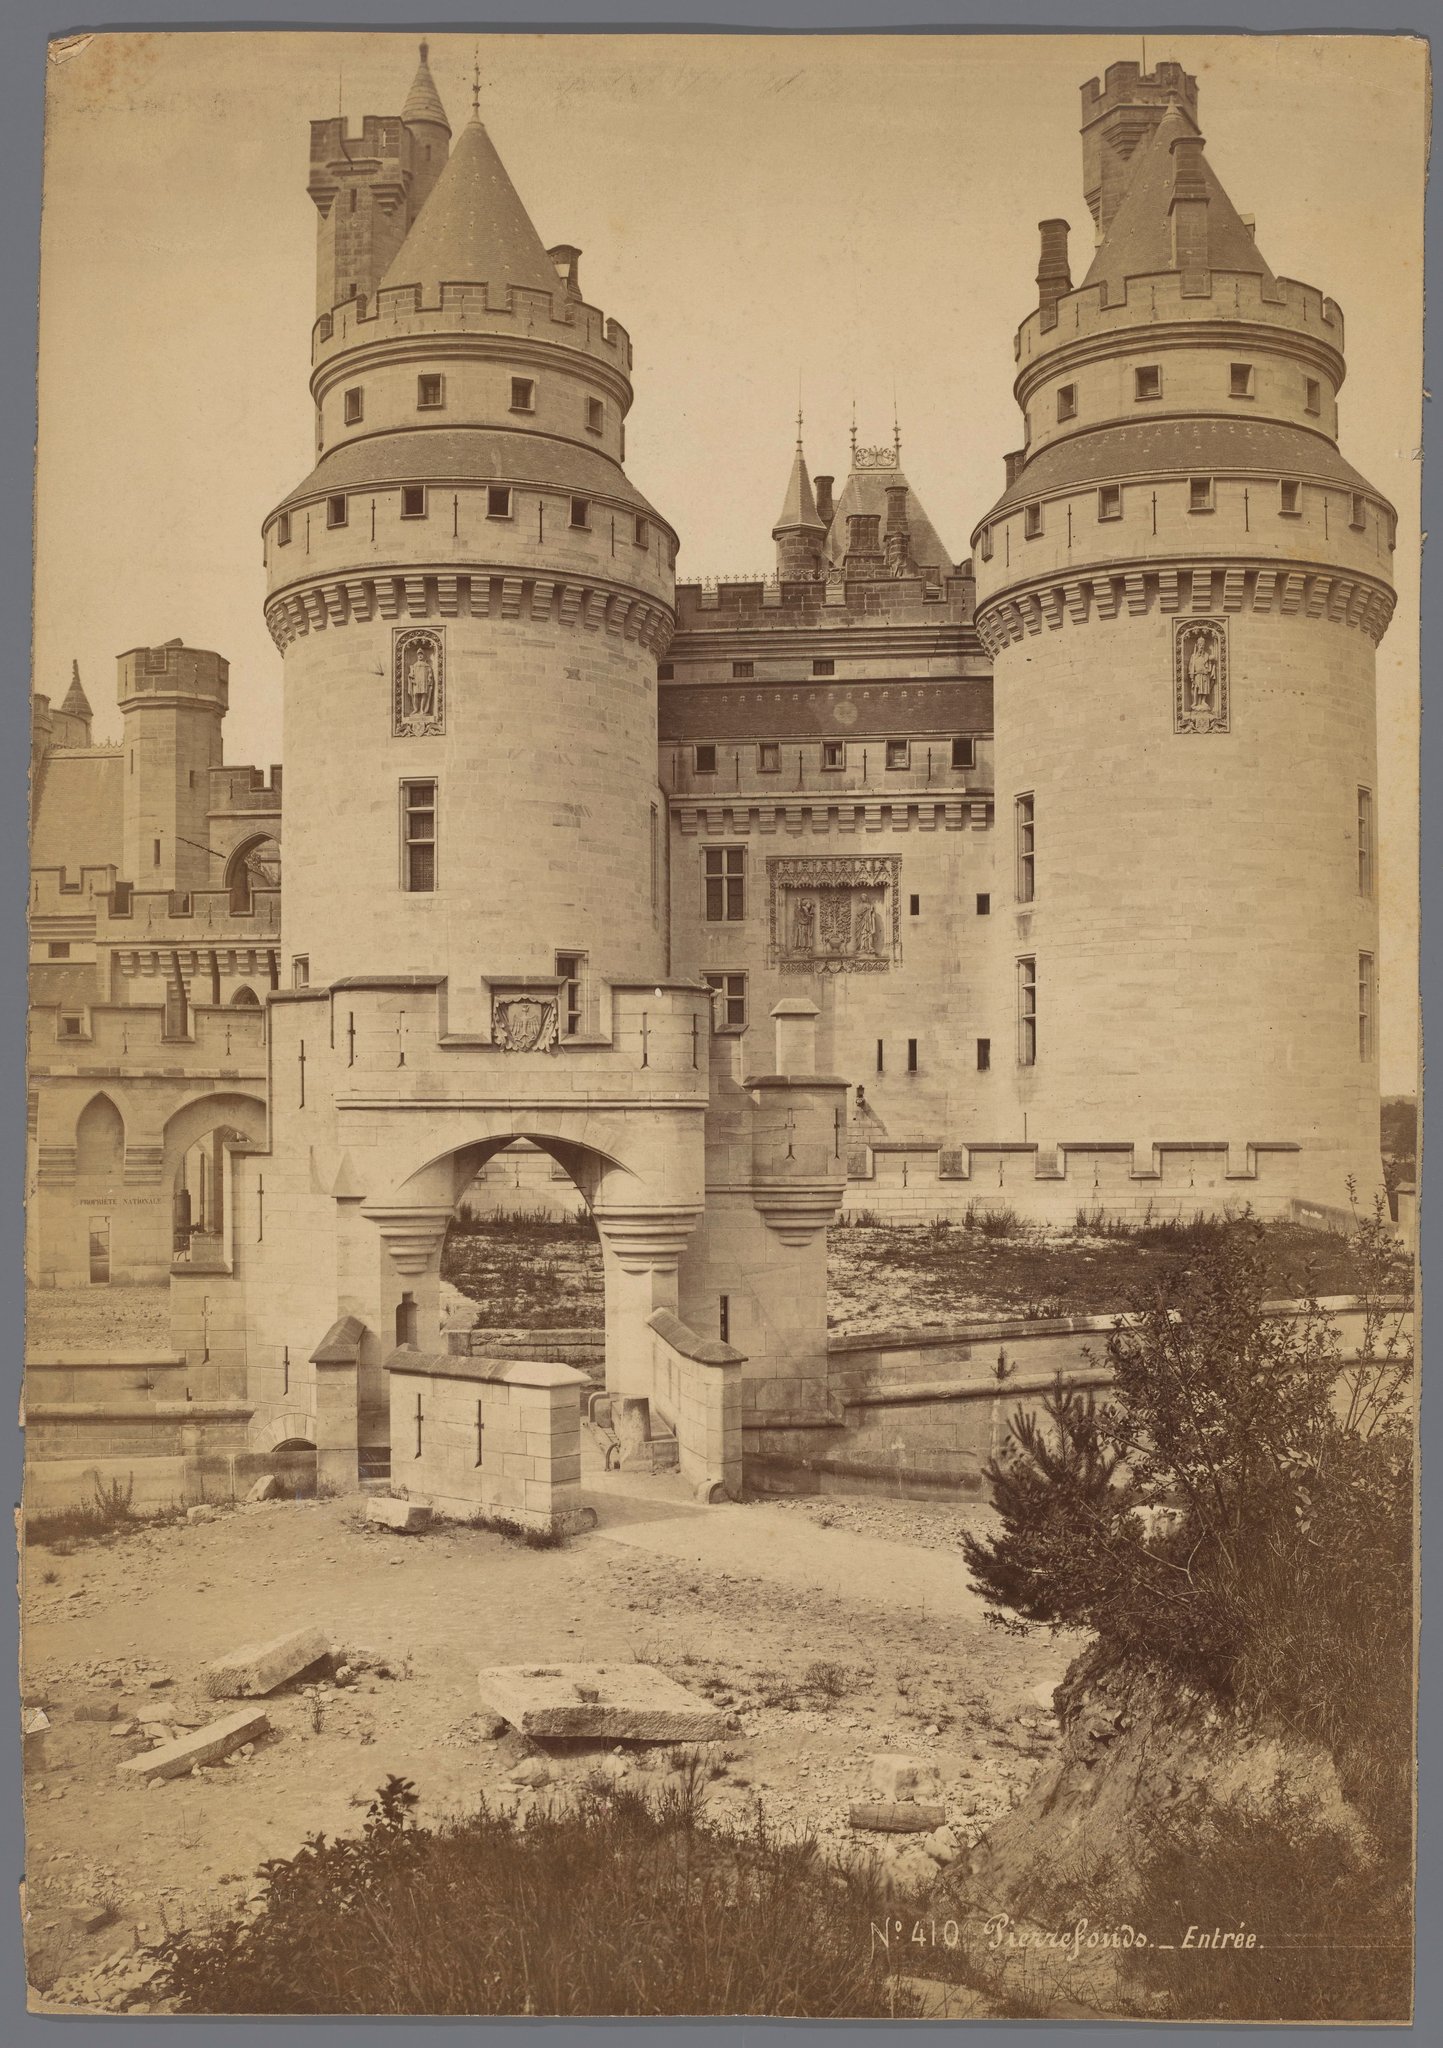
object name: photograph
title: Gezicht op het kasteel van Pierrefonds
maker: Anonymous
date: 1850-1900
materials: cardboard, photographic support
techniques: albumen print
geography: pierrefonds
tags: castle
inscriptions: number: ‘No. 410’, collector's mark: ‘Rijks-normaalschool voor teekenonderwijzers Amsterdam’ Lugt 3937, inscription: ‘Pierrefonds._Entrée.’